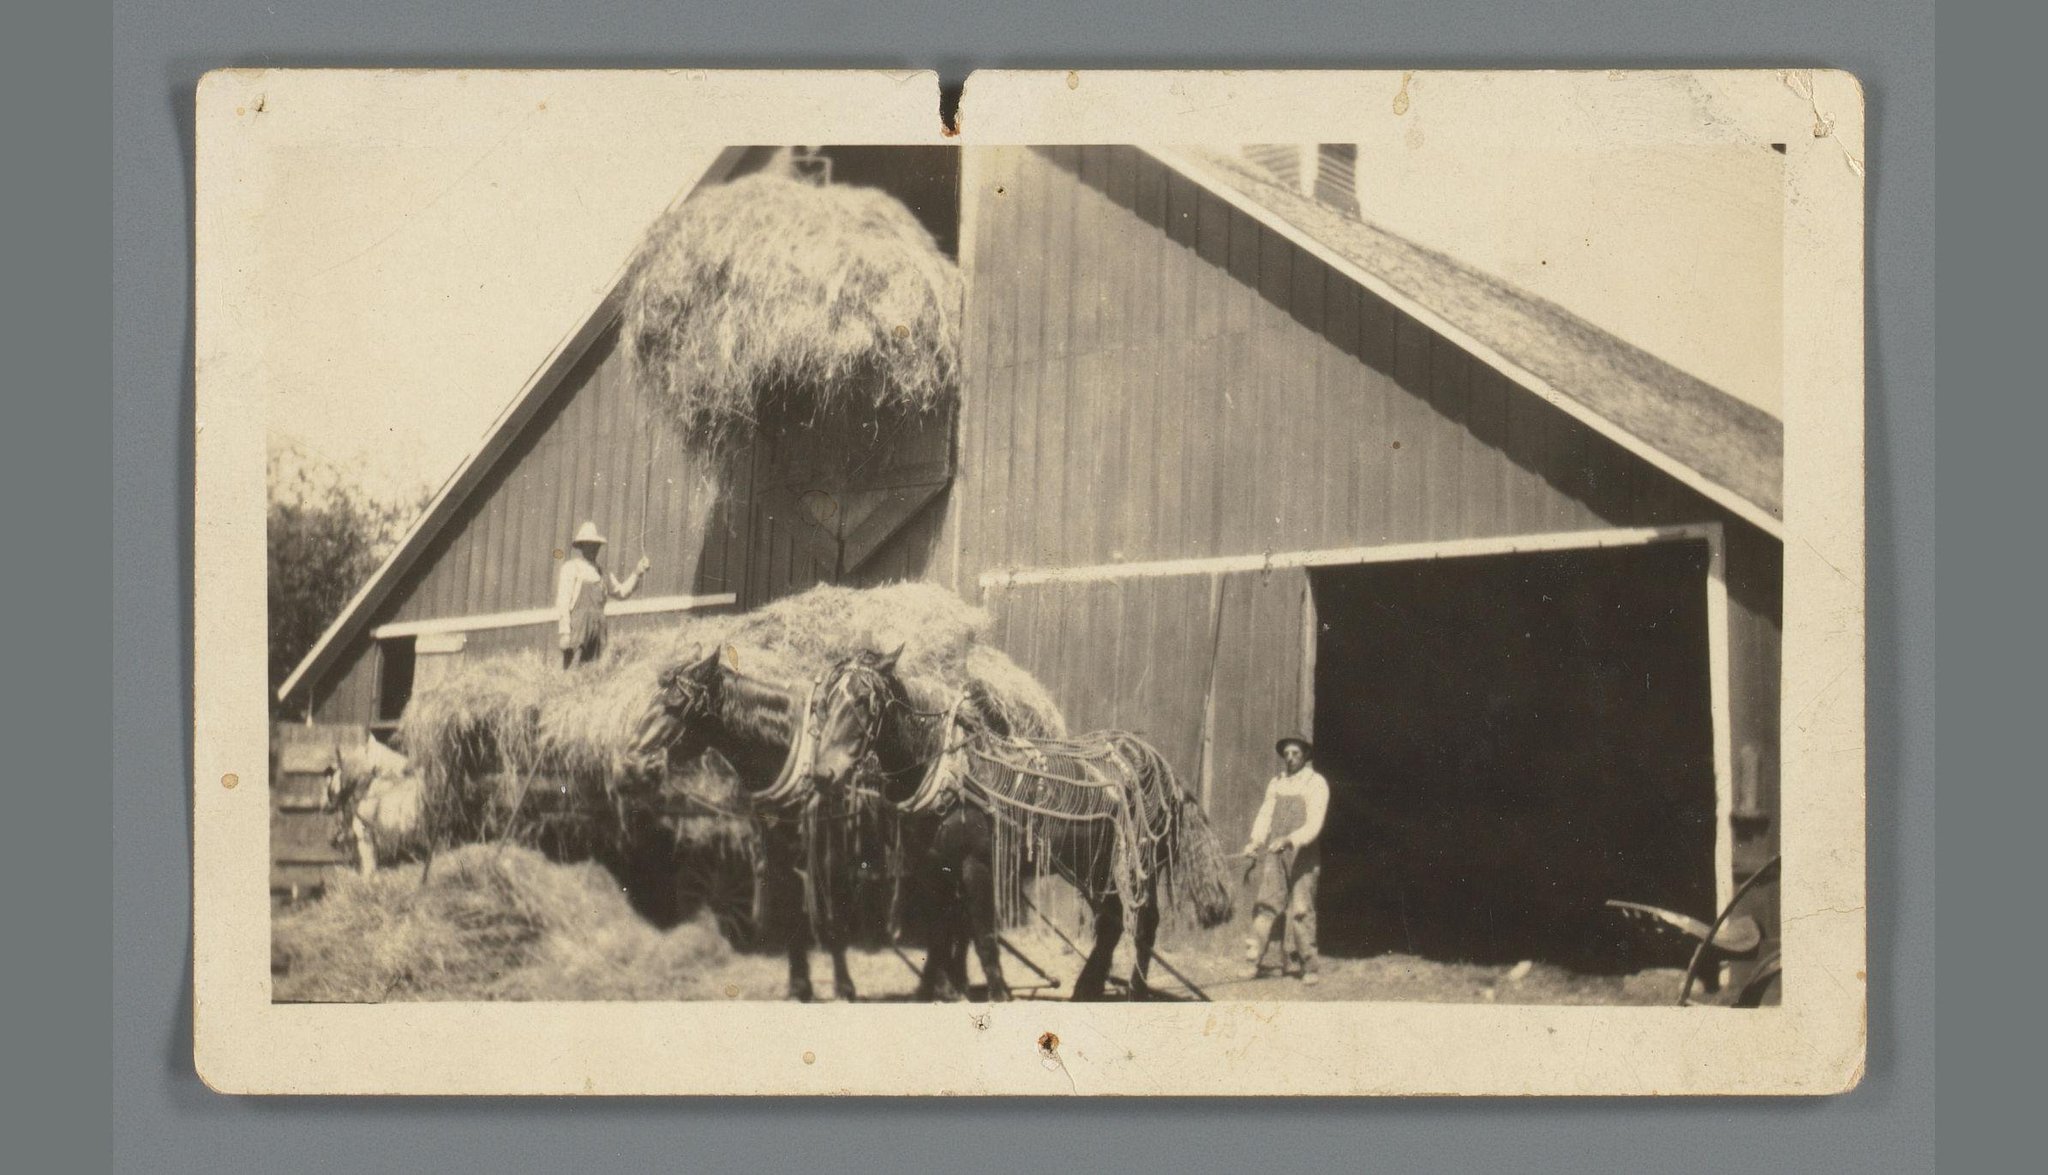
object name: photograph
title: Twee mannen met paarden bij een hooischuur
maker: Anonymous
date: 1920-1950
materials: paper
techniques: gelatin silver print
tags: barn, hay-stack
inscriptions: stamp: ‘[...]1 2/ Service’